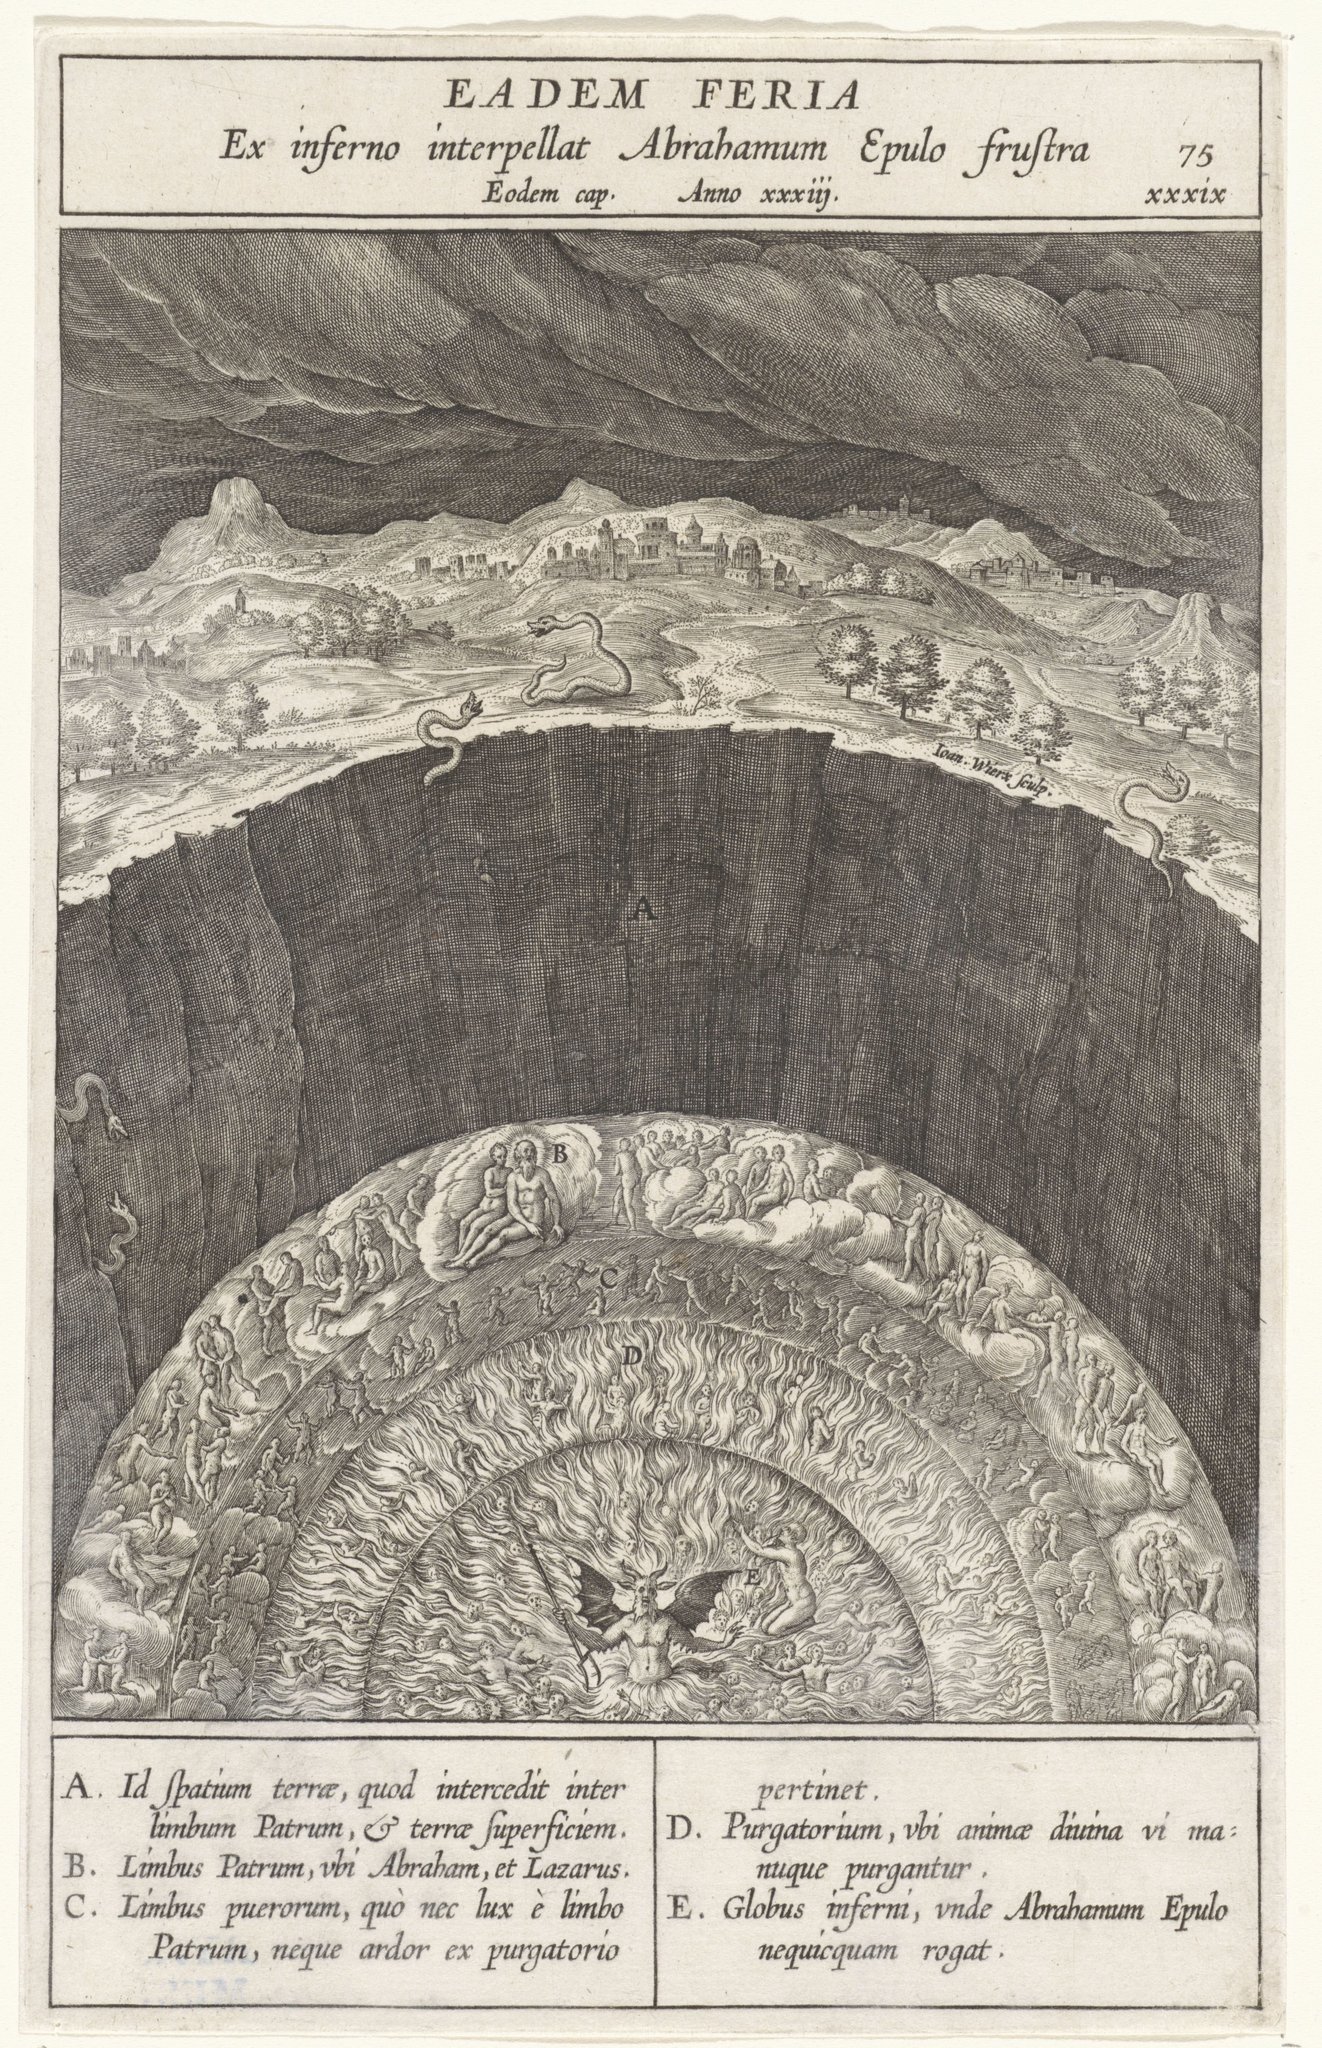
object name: print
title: Eadem Feria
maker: johannes wierix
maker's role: draughtsman, print maker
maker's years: 1549-1618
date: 1593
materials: paper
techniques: engraving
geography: antwerp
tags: in hell dives sees lazarus in paradise; usually dives pointing at his tongue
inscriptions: collector's mark: Lugt 2165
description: De rijke man brandt in de hel en wordt door duivels bedreigd. Hij ziet Lazarus in de hemel op de schoot van Abraham. Bij verschillende elementen uit de voorstelling staan letters die corresponderen met de legenda in de marge.